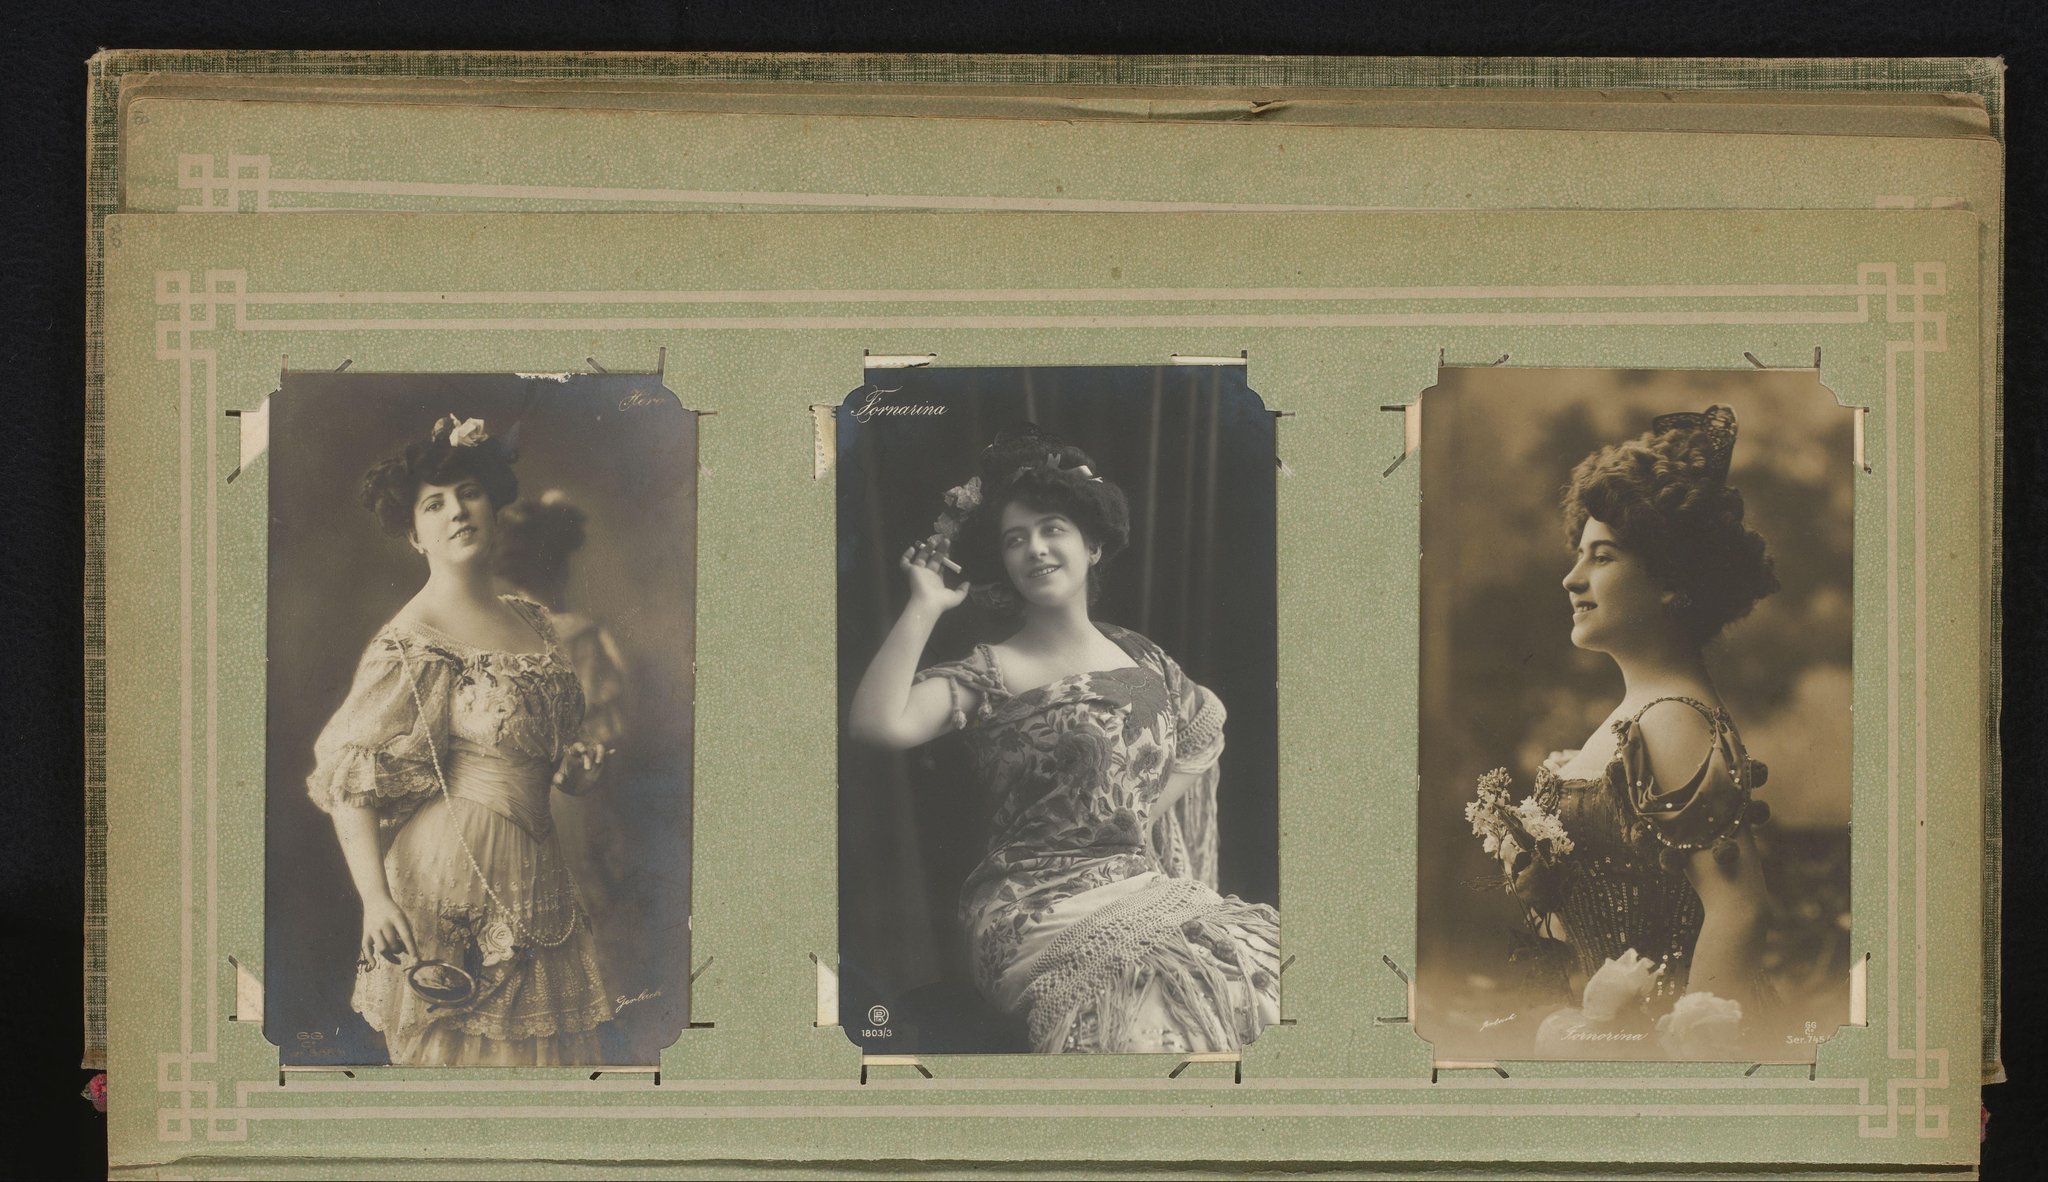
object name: photograph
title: Drie portretten van actrices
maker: Anonymous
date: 1900-1930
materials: cardboard, photographic support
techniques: gelatin silver print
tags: historical persons - bb - woman, portrait of actor, actress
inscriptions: monogram: ‘R/H’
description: Deze foto's maken deel uit van een album.